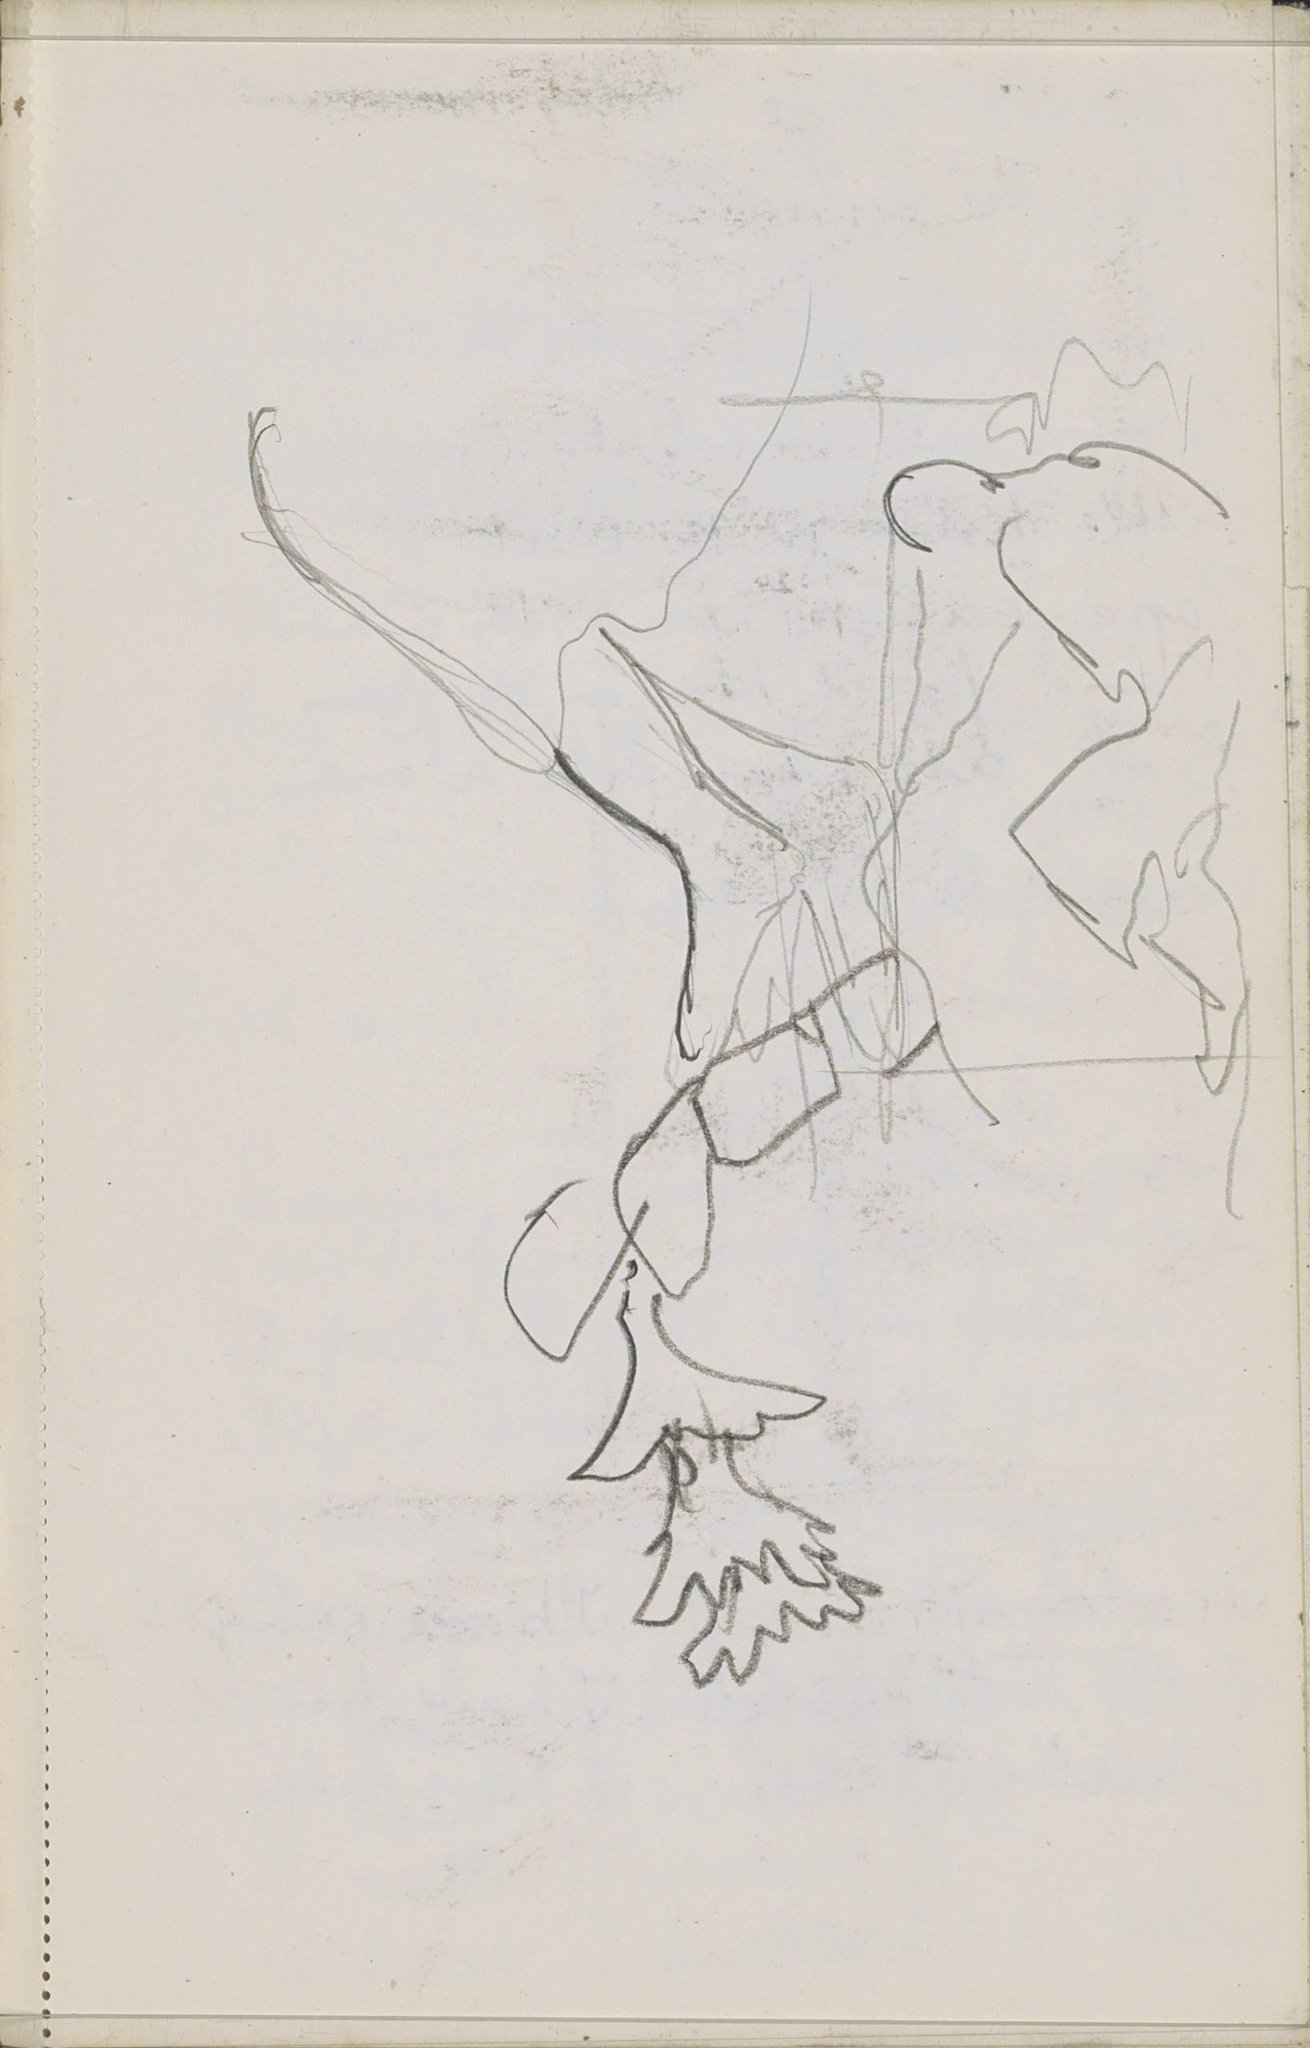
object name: sketchbook leaf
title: Studie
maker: cornelis vreedenburgh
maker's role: draughtsman, print maker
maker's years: 1880-1946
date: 1890-1946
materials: chalk, paper, pencil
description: Mogelijk een plant of bloem. Blad 51 recto uit een schetsboek met 53 bladen.